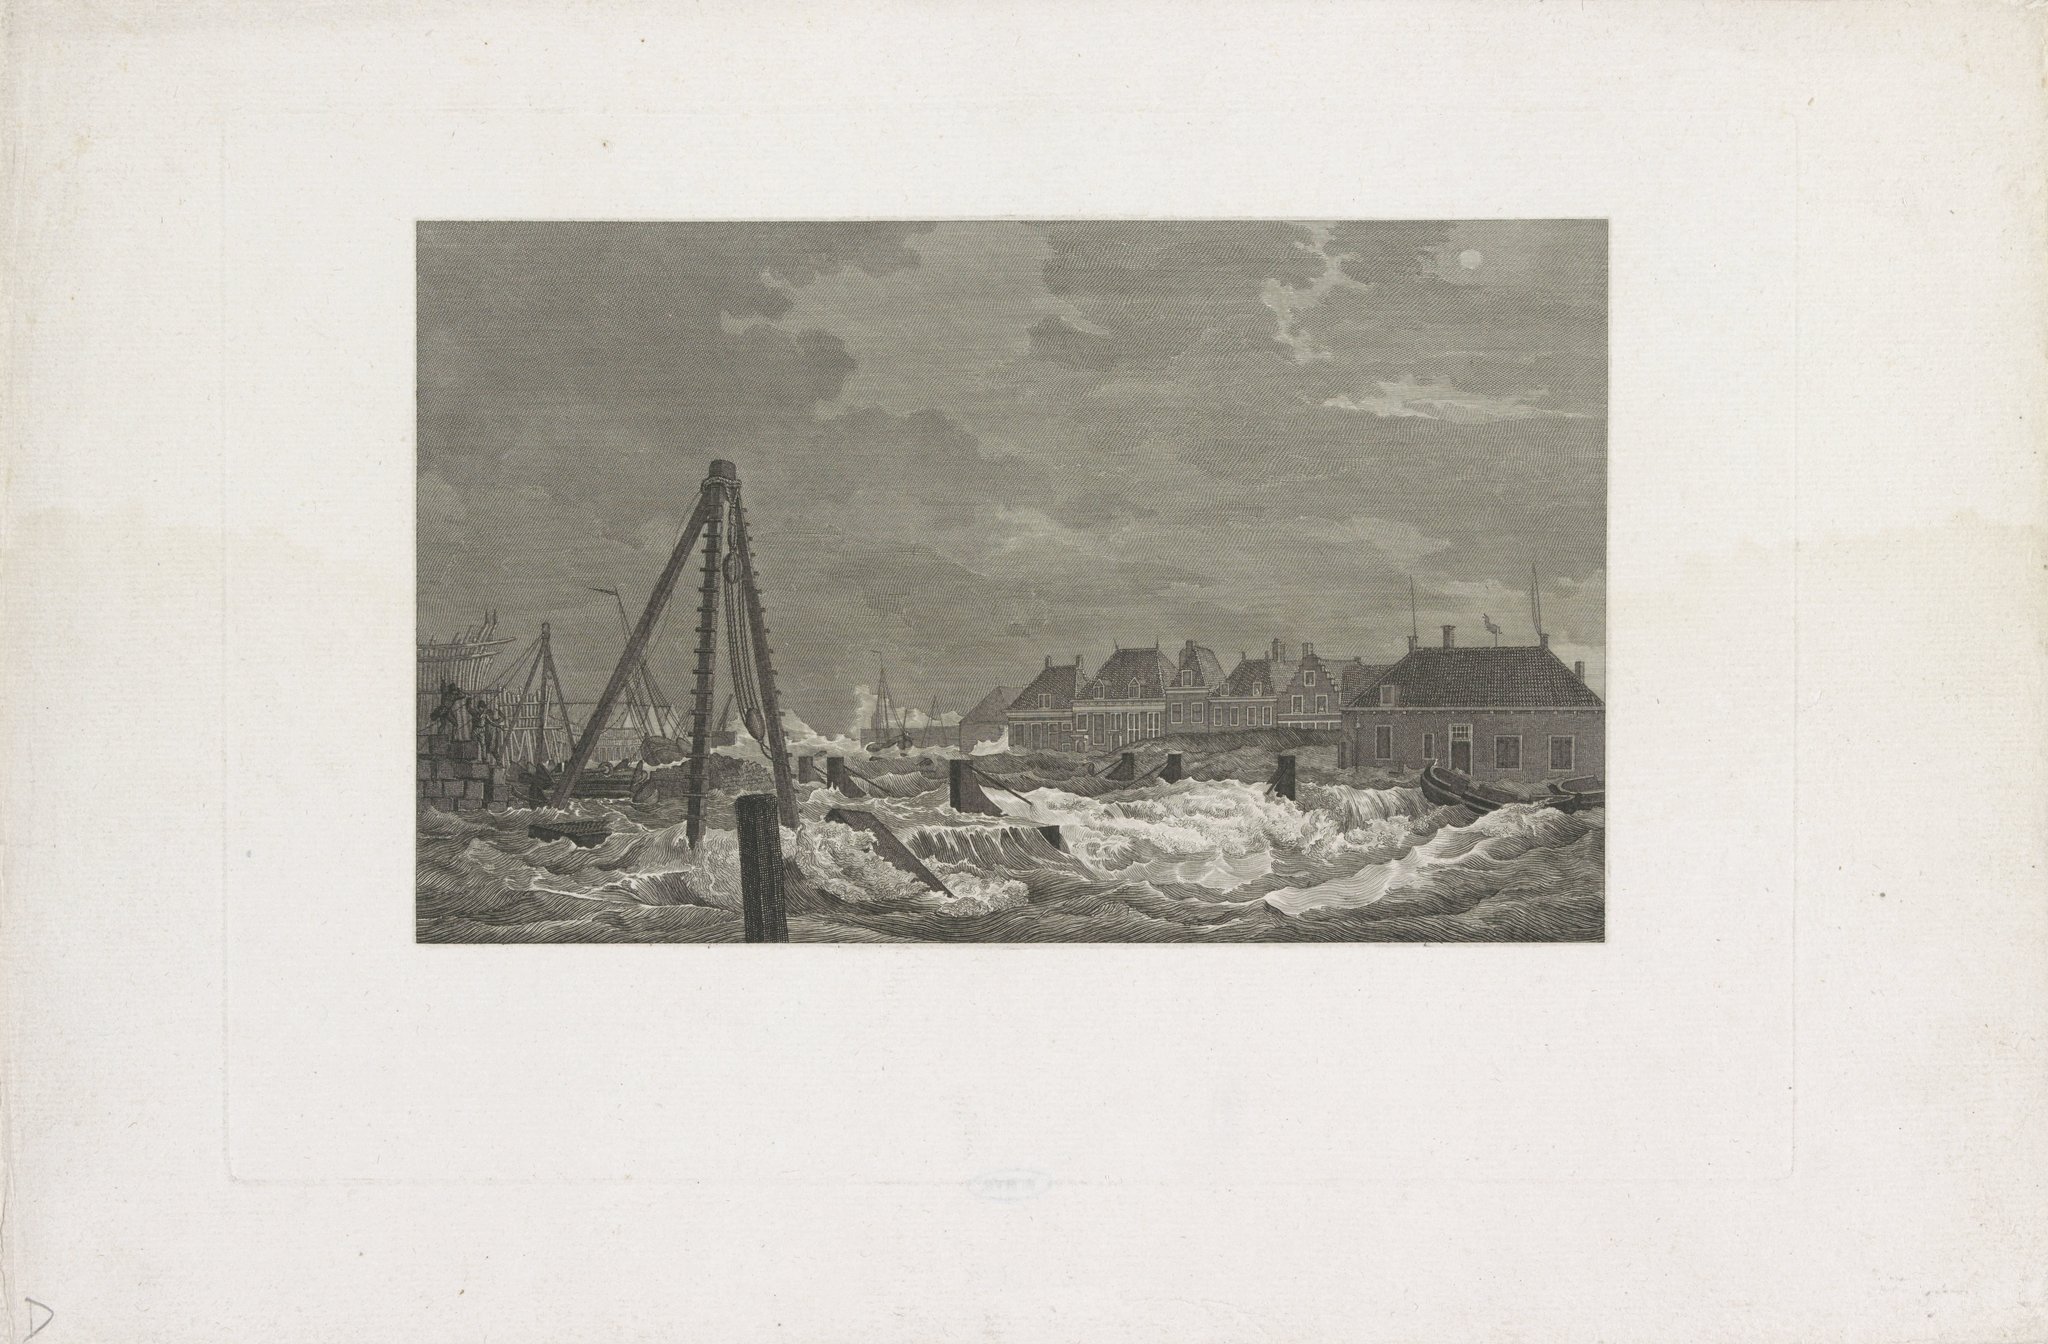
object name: print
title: Overstroming bij de Nieuwe Haven, Wijnbergse Kaai en werf te Vlissingen, 1808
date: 1808-1810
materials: paper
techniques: engraving, etching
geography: netherlands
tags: flood, flushing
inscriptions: collector's mark: Lugt 2228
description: Gebruikt als illustratie in: Sander van Hoek, Natuur- en geschiedkundige beschrijving van den verschrikkelijken watervloed tusschen den XIVden en XVden van louwmaand des jaars MDCCCVIII. 3 dln. Haarlem: Adriaan Loosjes Pz., 1808-1810.